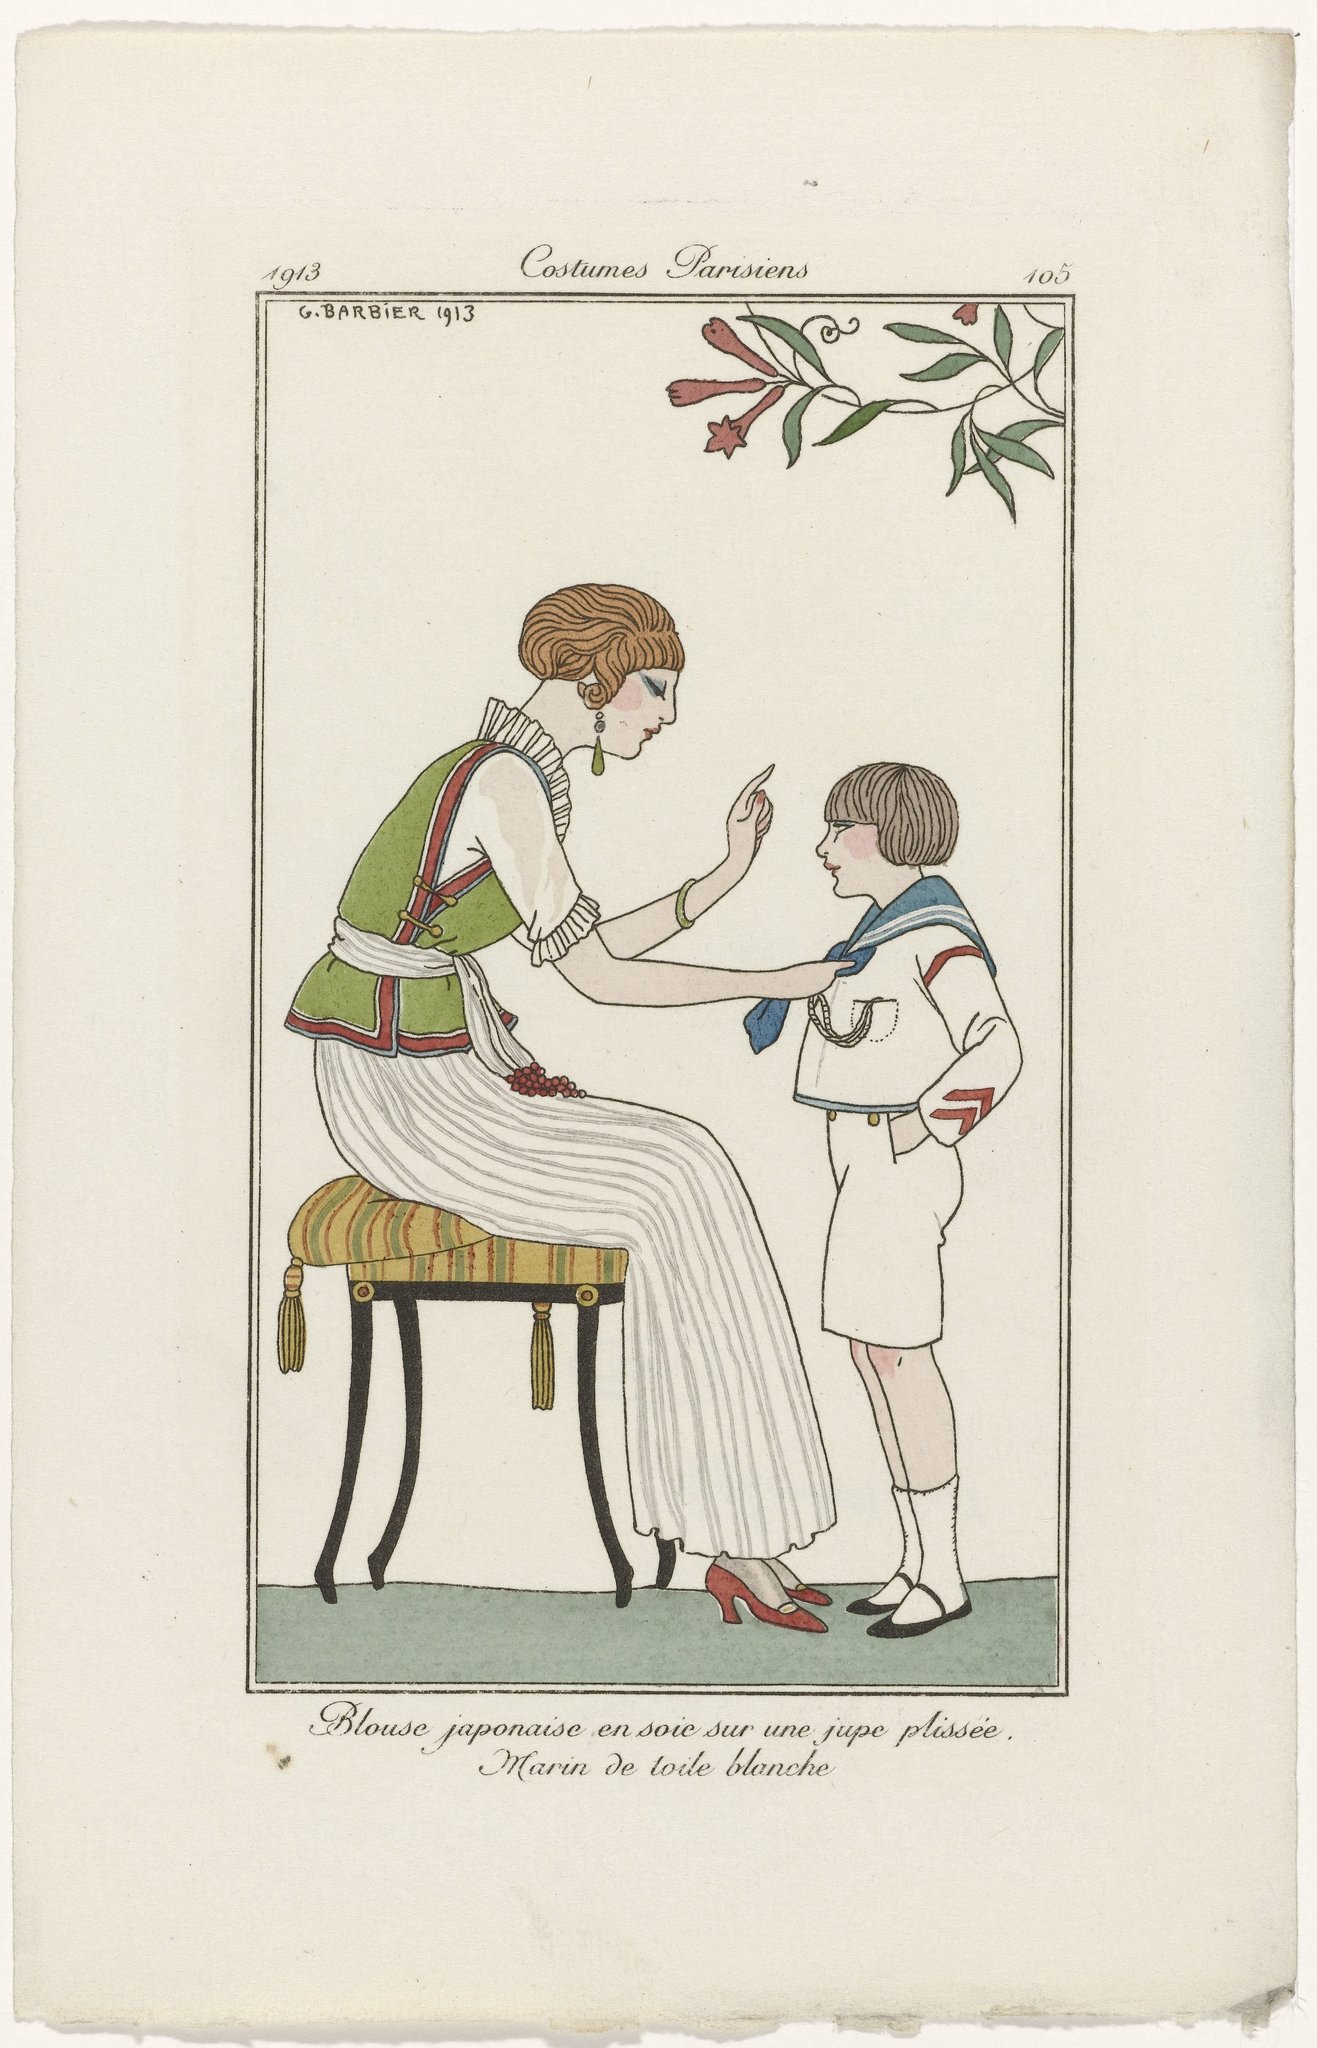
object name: fashion print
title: Journal des Dames et des Modes, Costumes Parisiens, 1913, No. 105 : Blouse japonais (...)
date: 1913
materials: paper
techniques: engraving, hand coloring, pochoir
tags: clothing for the upper part of the body: blouse (+ women's clothes), sailor (+ variant), clothes, costume (+ boys' clothes), fashion plates, skirt (+ women's clothes), belt, girdle, waistband (+ women's clothes)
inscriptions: caption: ‘Blouse japonaise en soie sur une jupe plissée. Marin de toile blanche’, title: ‘Costumes Parisiens’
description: Vrouw, zittend op een kruk, gekleed in een zijden Japanse blouse op een plooirok. Voor haar staat een jongen in een matrozenpak van witte stof. Prent uit het modetijdschrift Journal des Dames et des Modes (1912-1914).